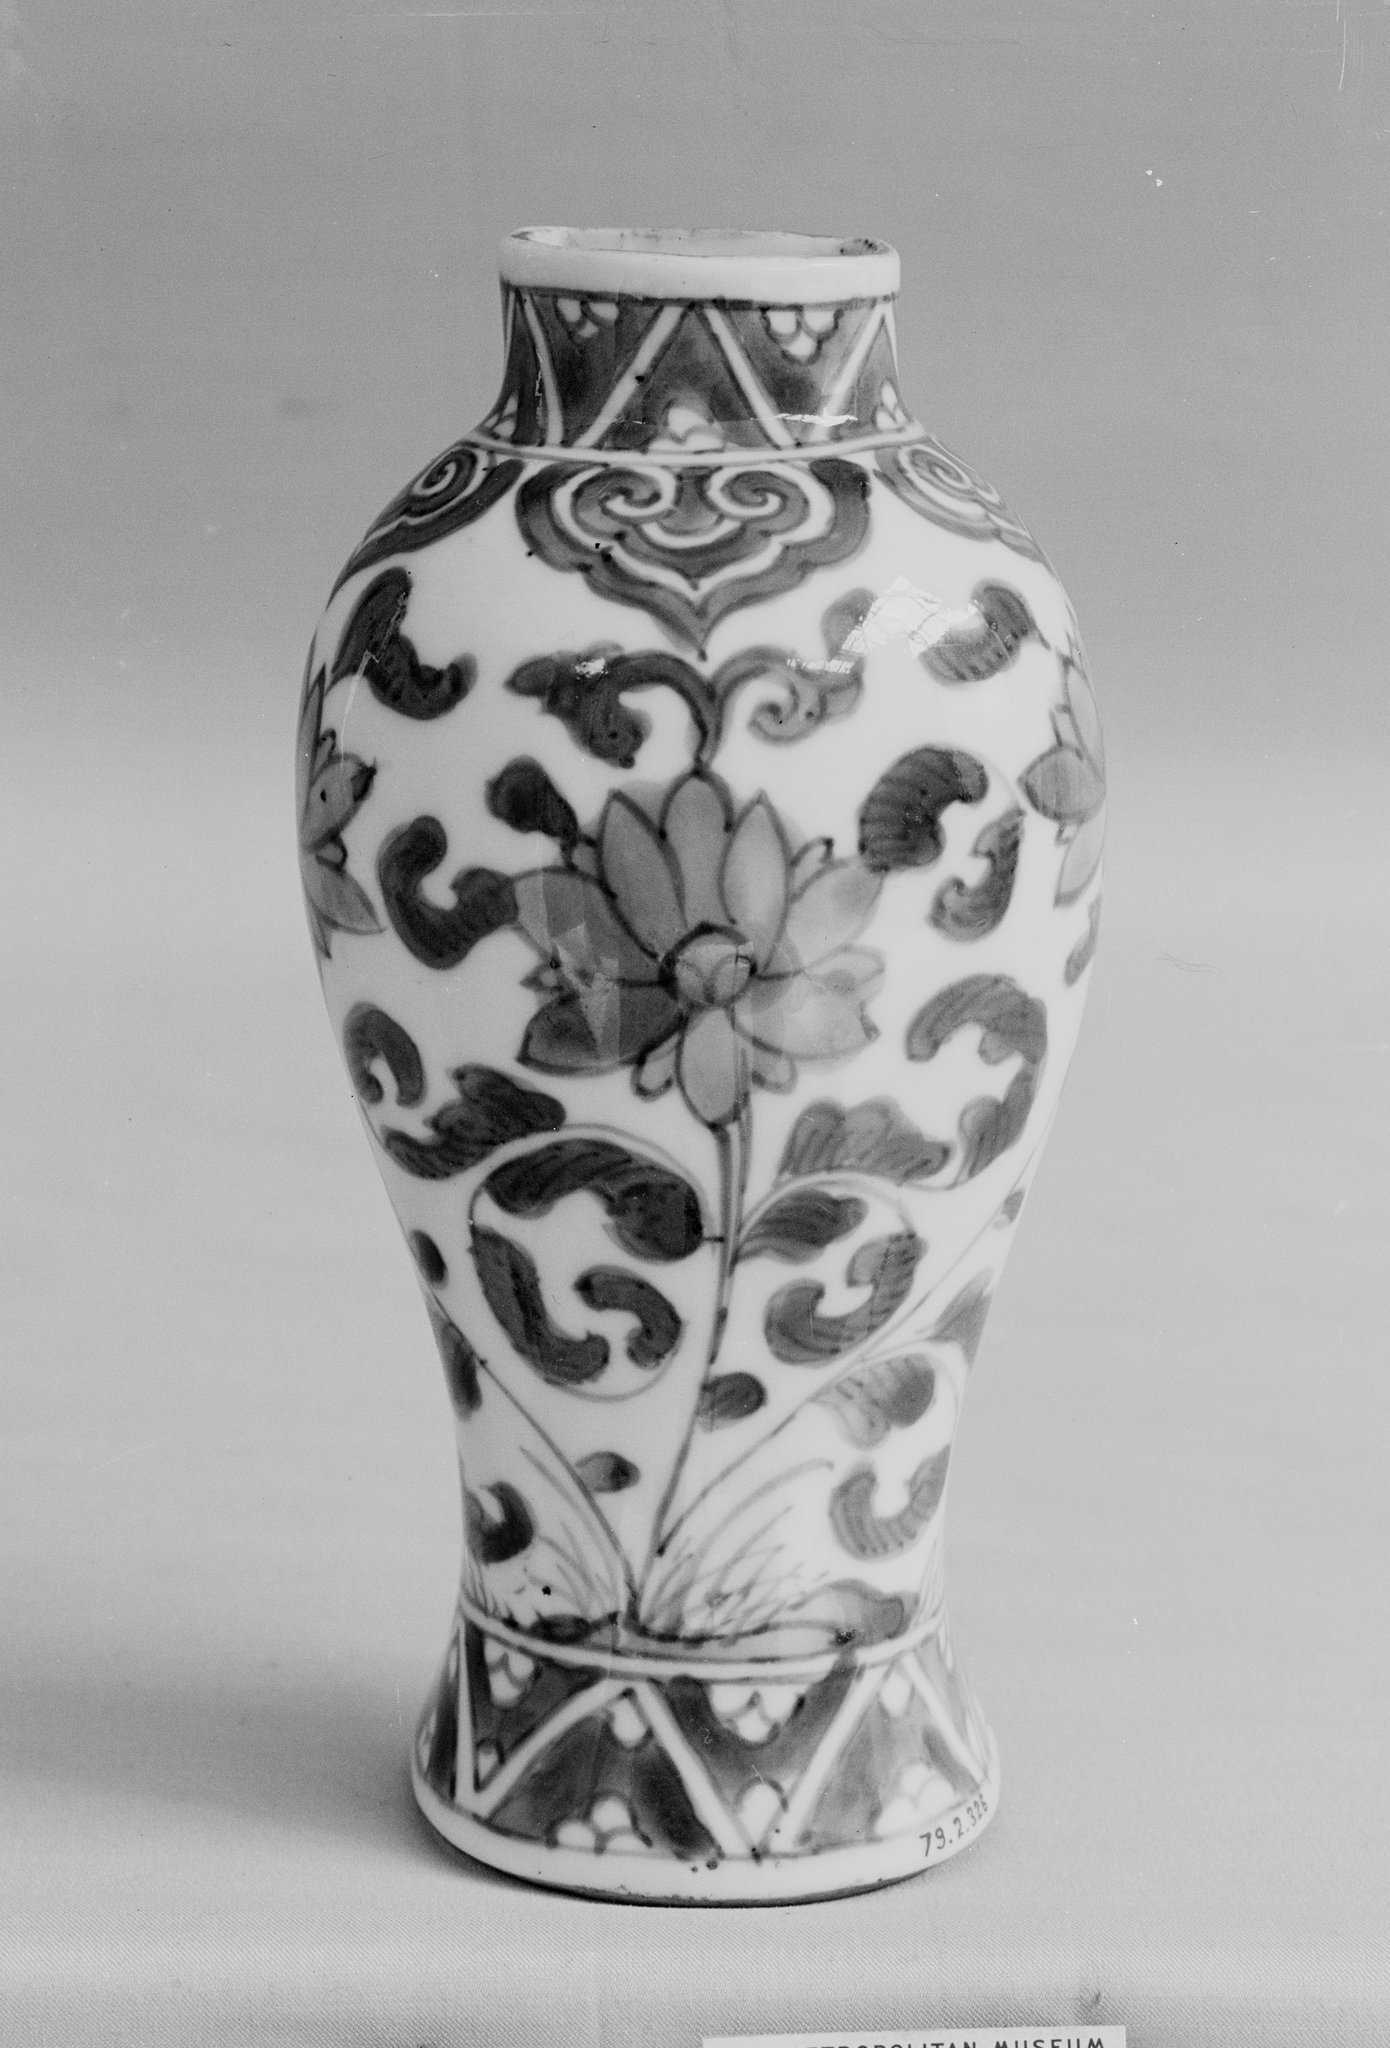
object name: vase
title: Hanging Vase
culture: japanese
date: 1801-1900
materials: glaze, porcelain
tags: flowers